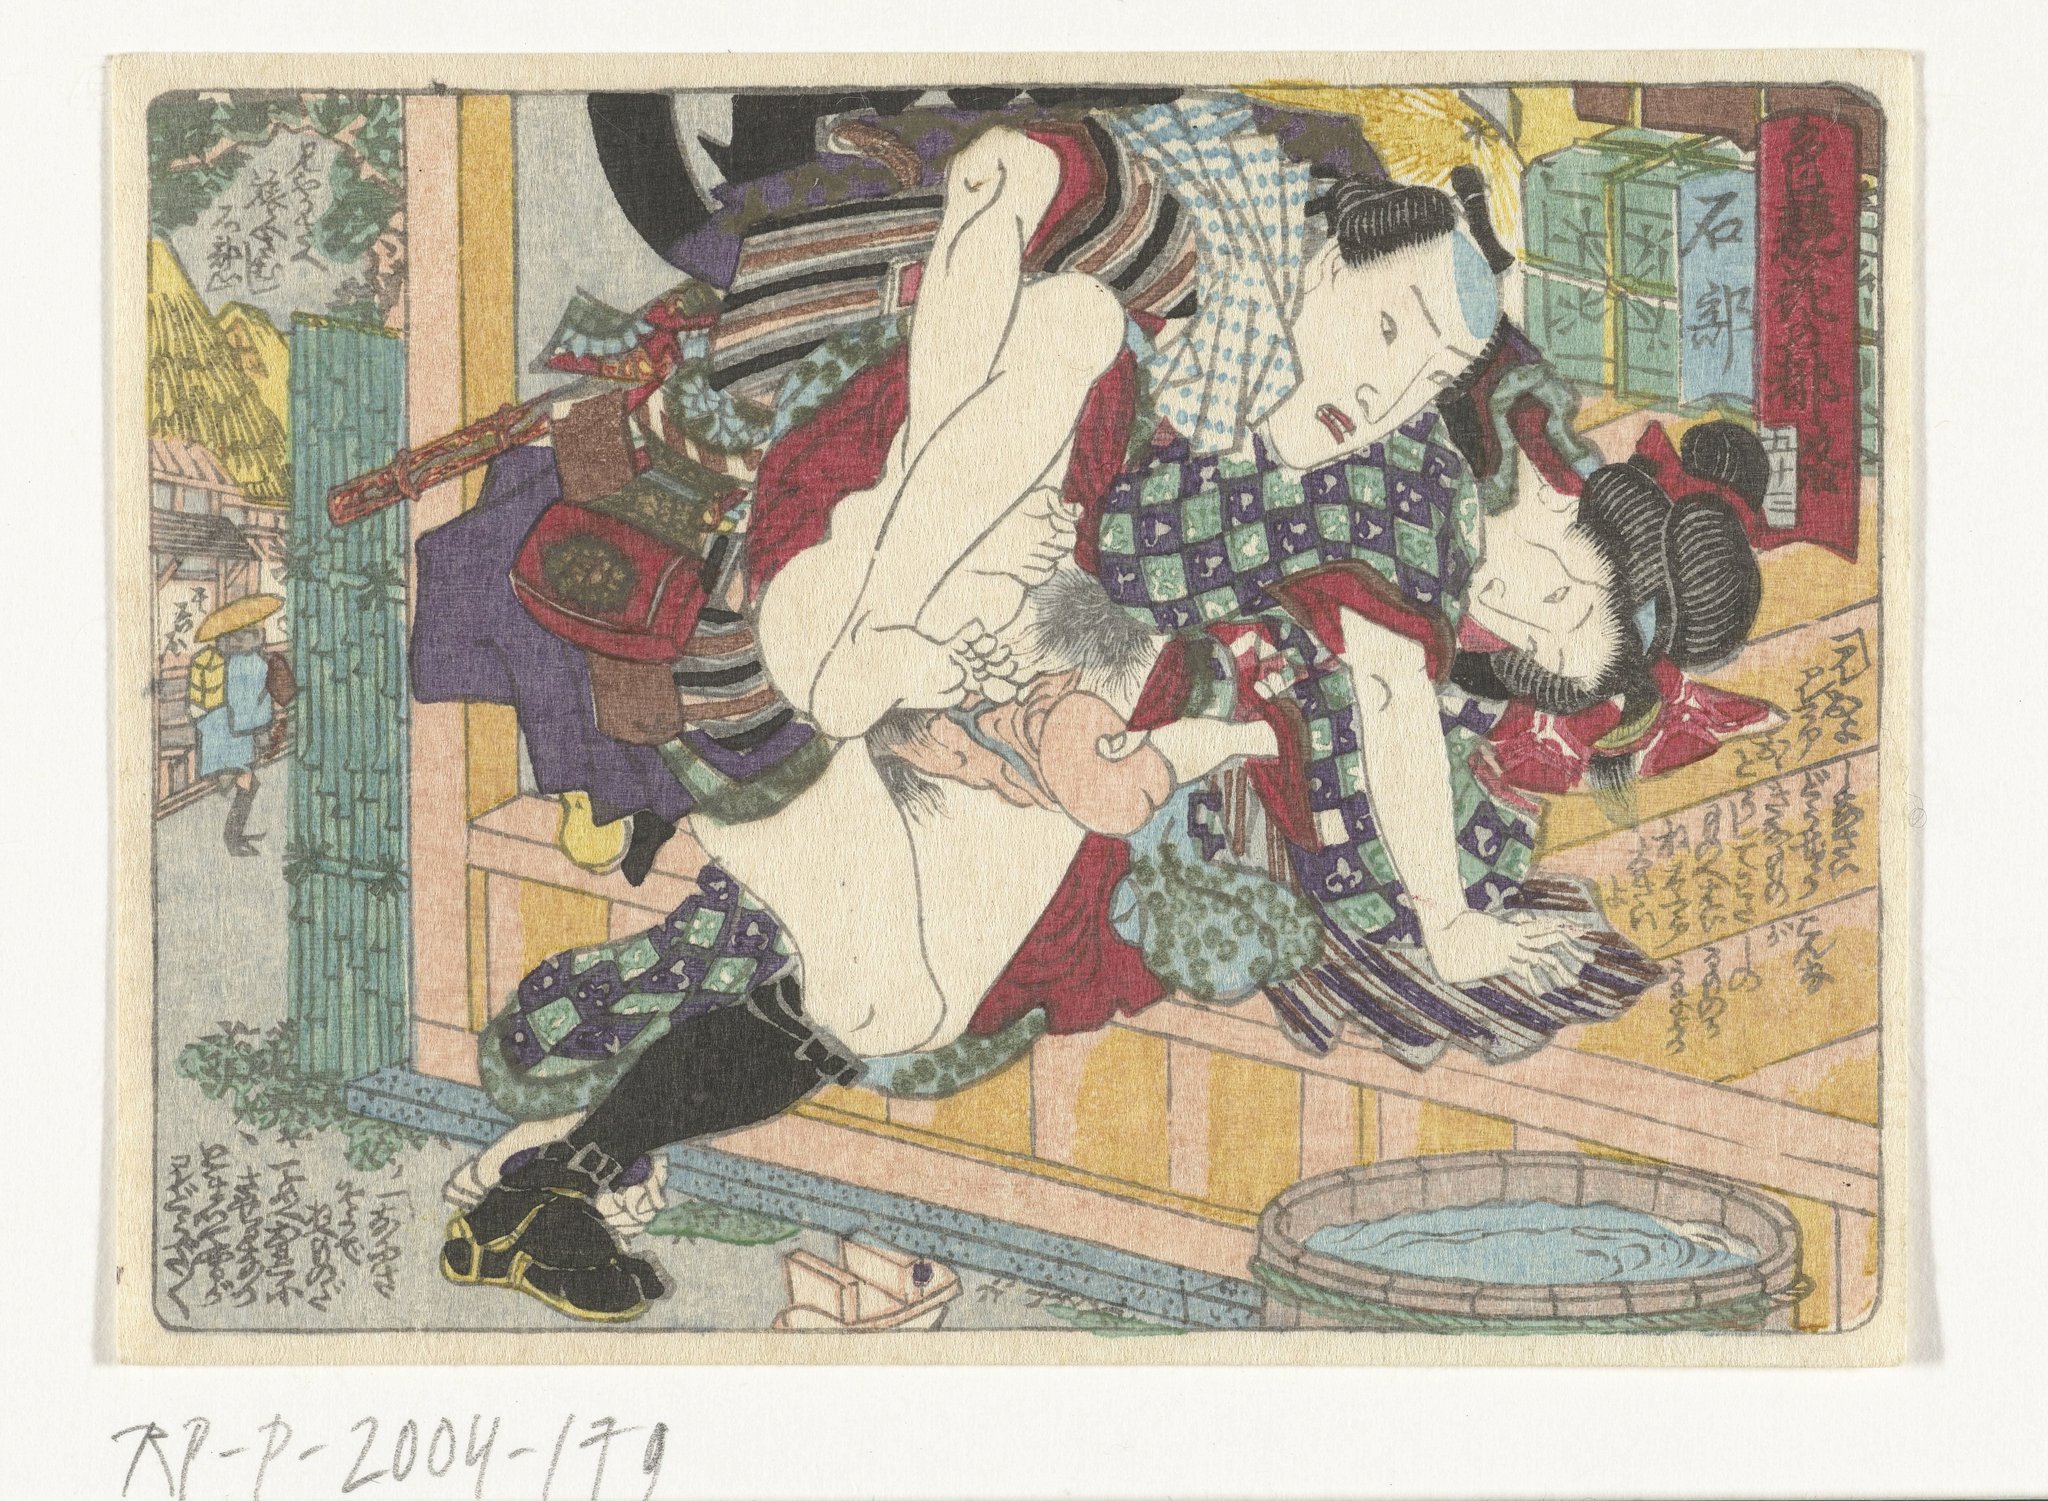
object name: print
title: Ishibe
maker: utagawa kunisada (i)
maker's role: print maker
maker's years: 1786-1865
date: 1835-1845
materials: paper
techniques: woodcut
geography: japan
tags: coitus, cohabiting, sexual intercourse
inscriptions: collector's mark: Lugt 2228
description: Man en vrouw de liefde bedrijvend in een zijstraatje, bij een winkel.